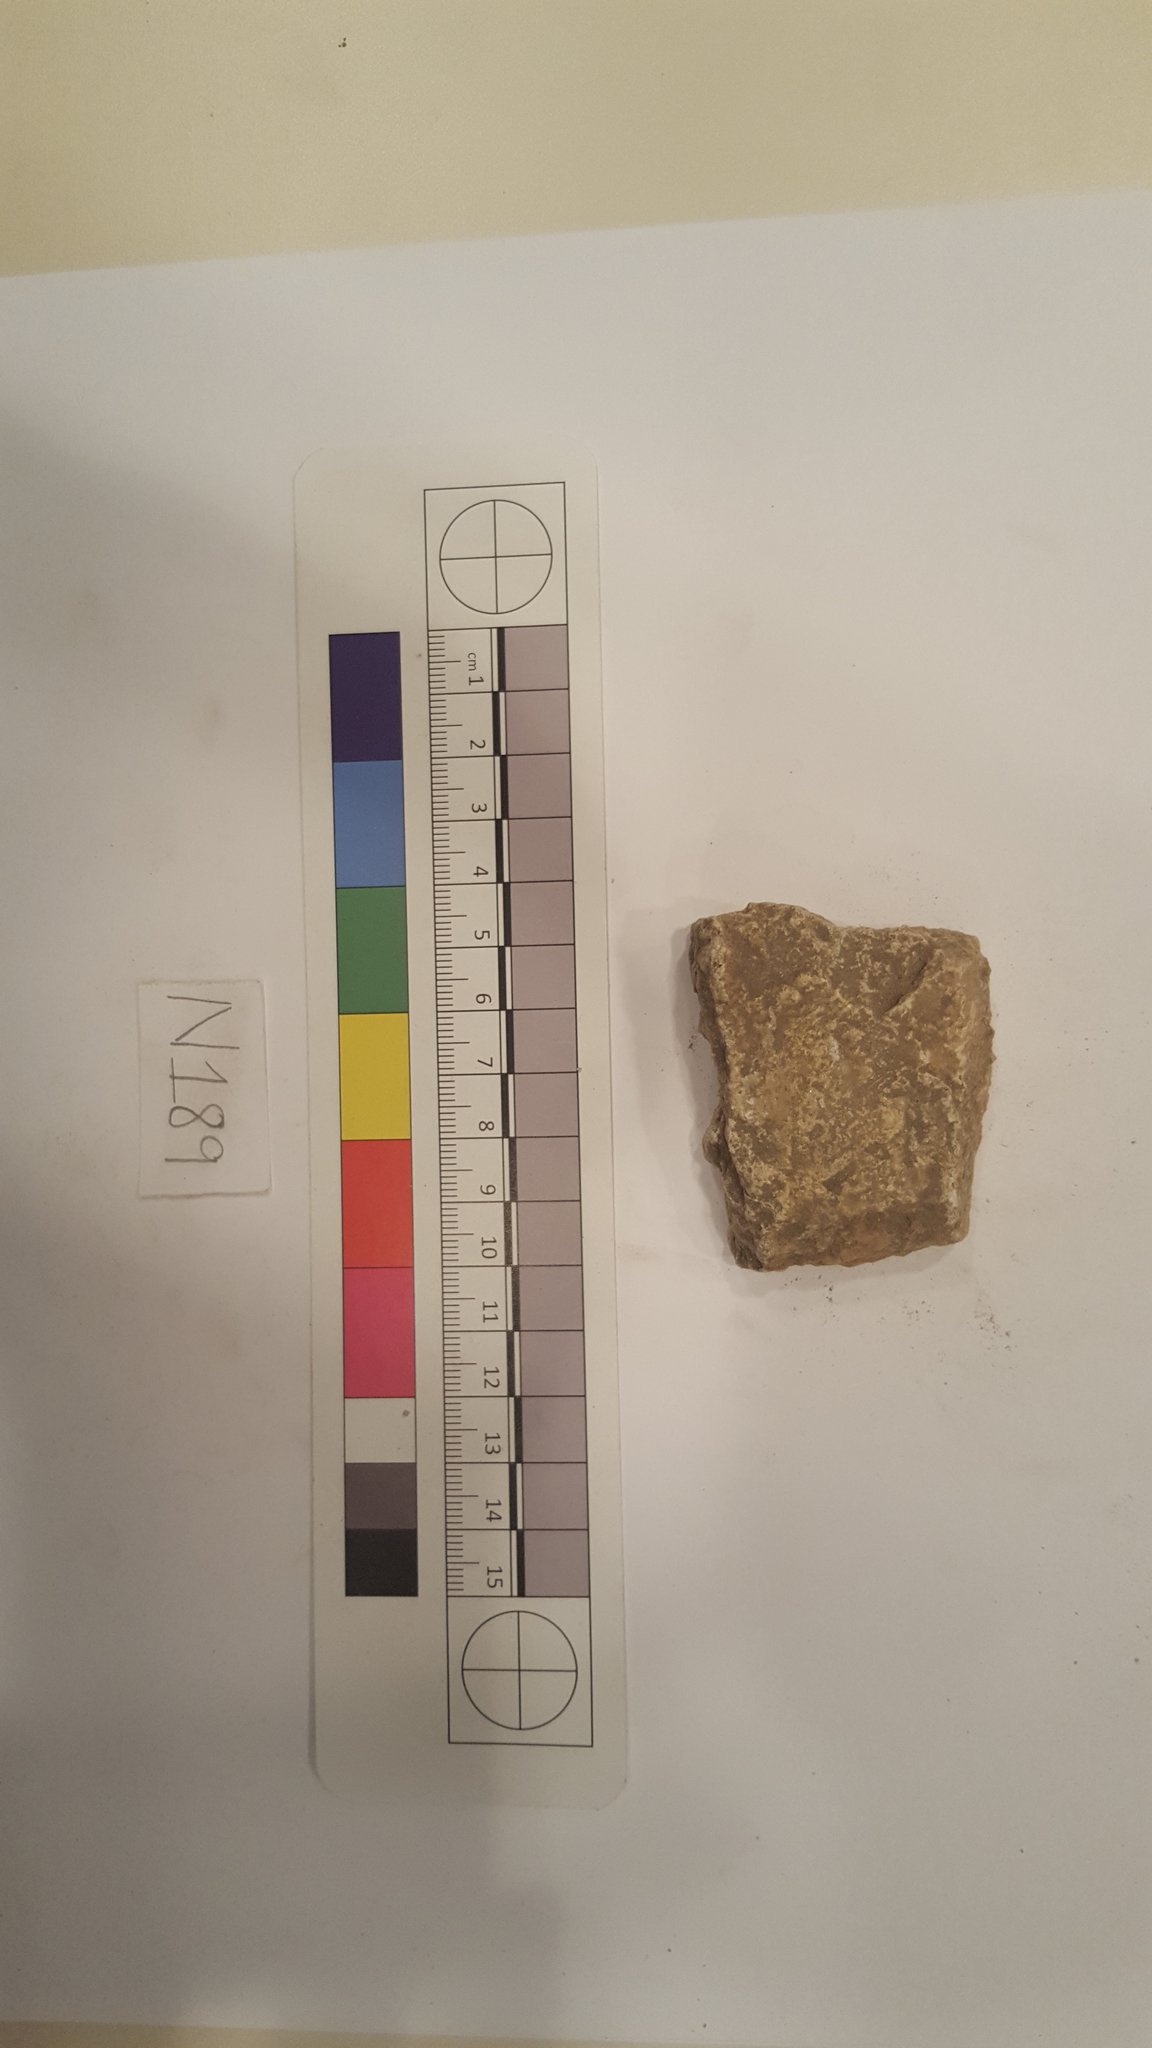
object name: fragment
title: Stucco Fragment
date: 701-1200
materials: plaster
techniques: carving, painting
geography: iran